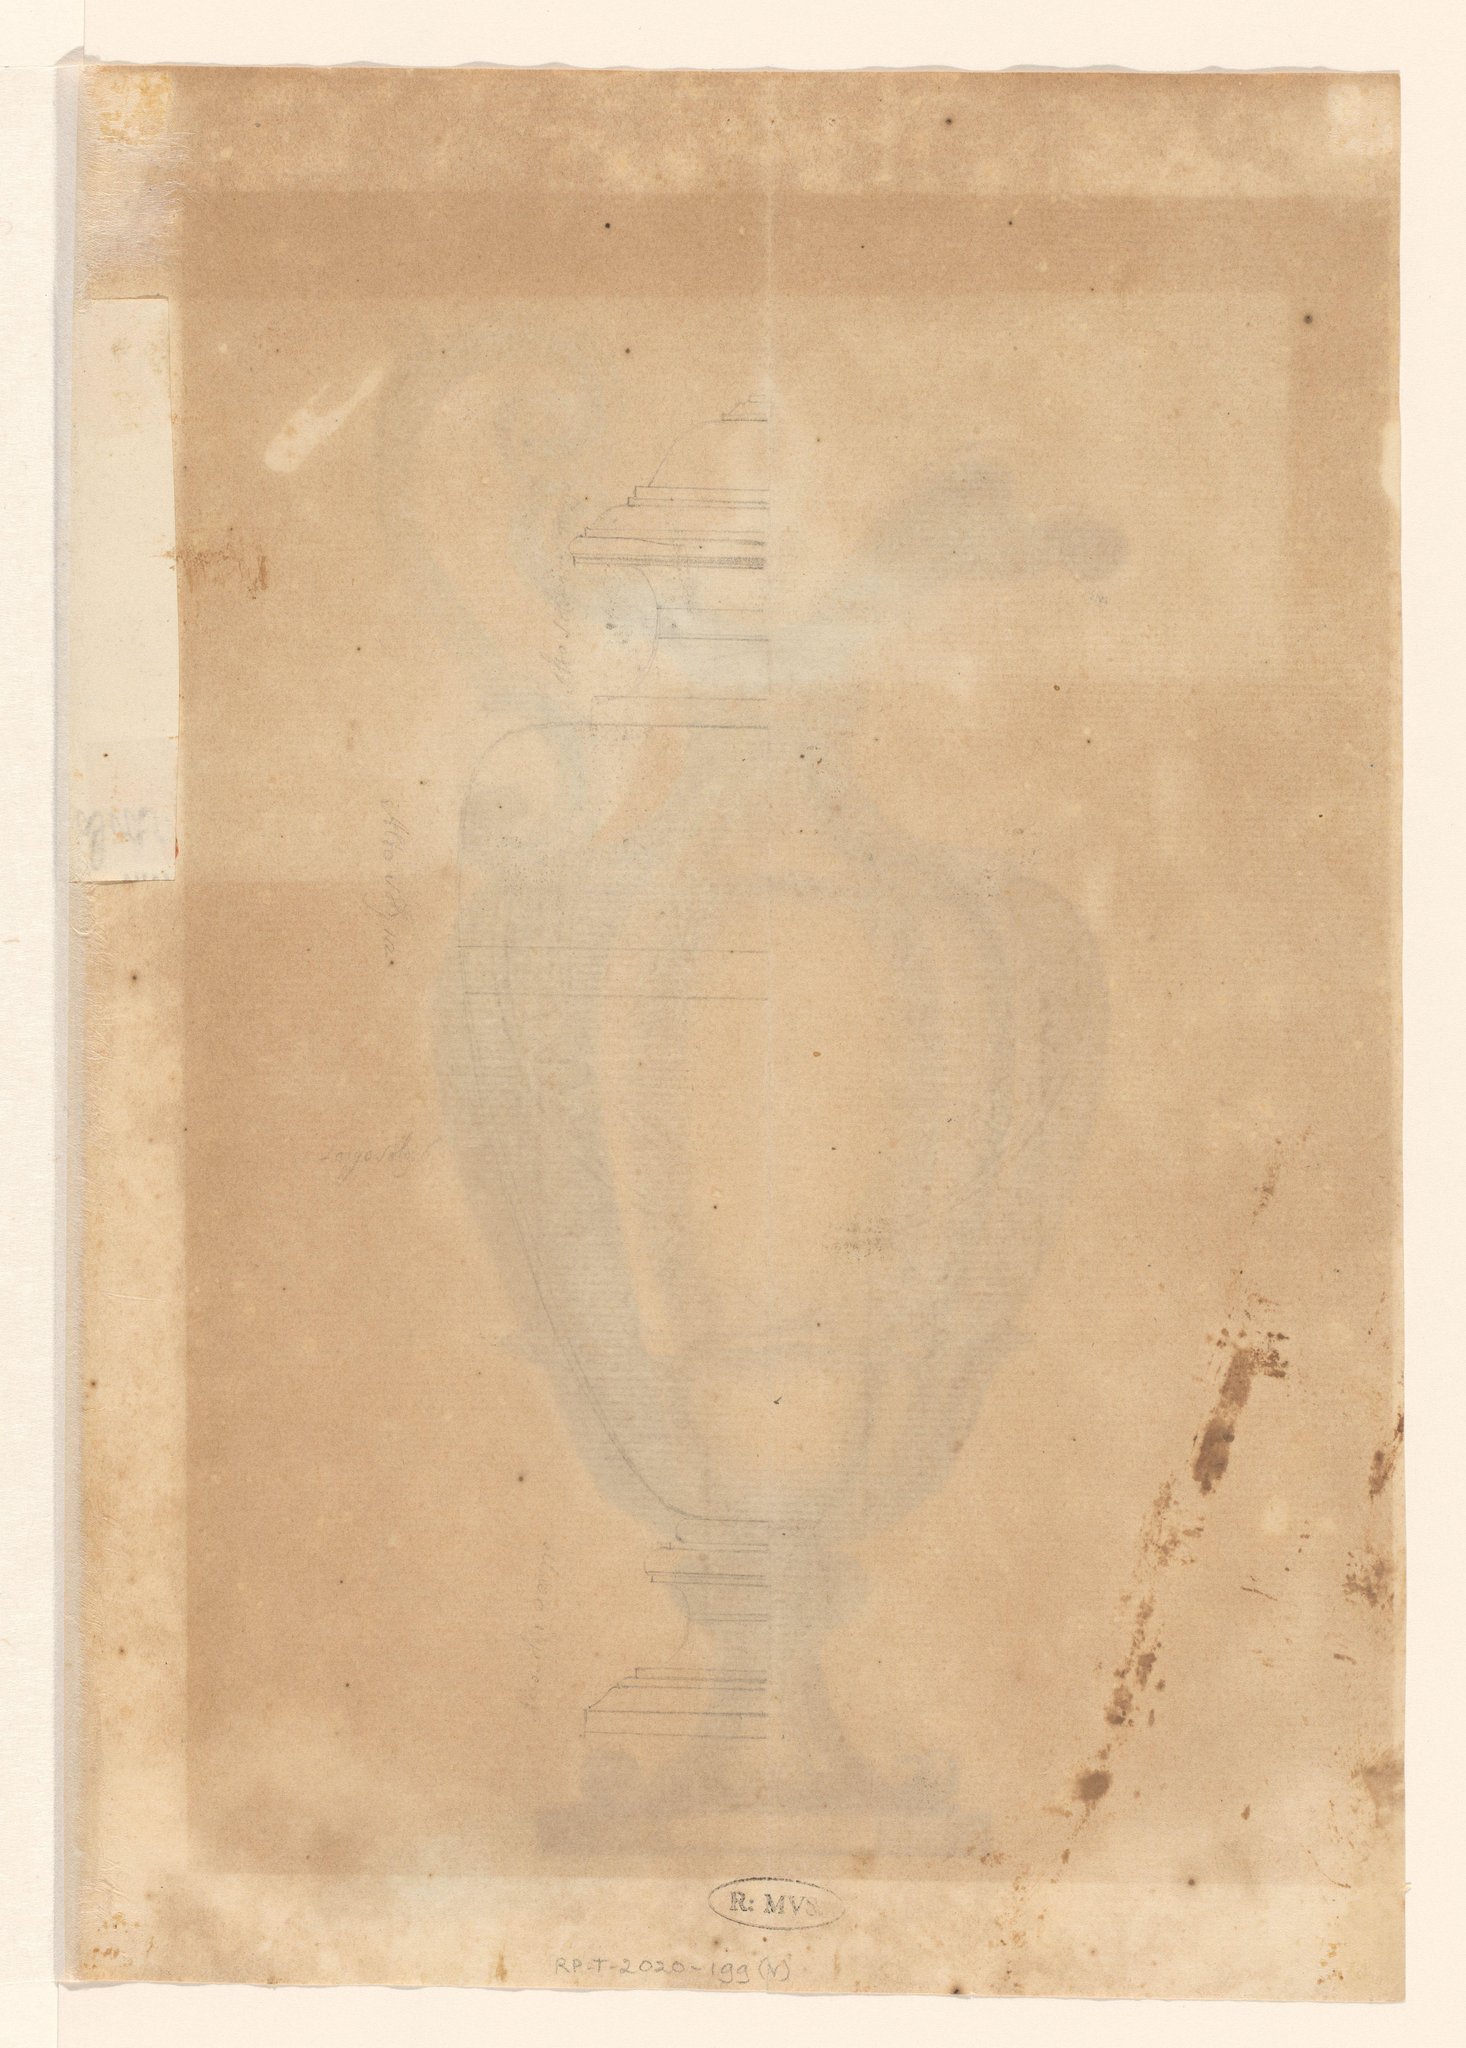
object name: design drawing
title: Linkerhelft van een dekselvaas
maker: Anonymous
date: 1710-1725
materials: chalk, paper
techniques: drawing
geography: italy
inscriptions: watermark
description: Linkerhelft van een dekselvaas met grotendeels uitgewiste opschriften in het Italiaans (Alto etc.)